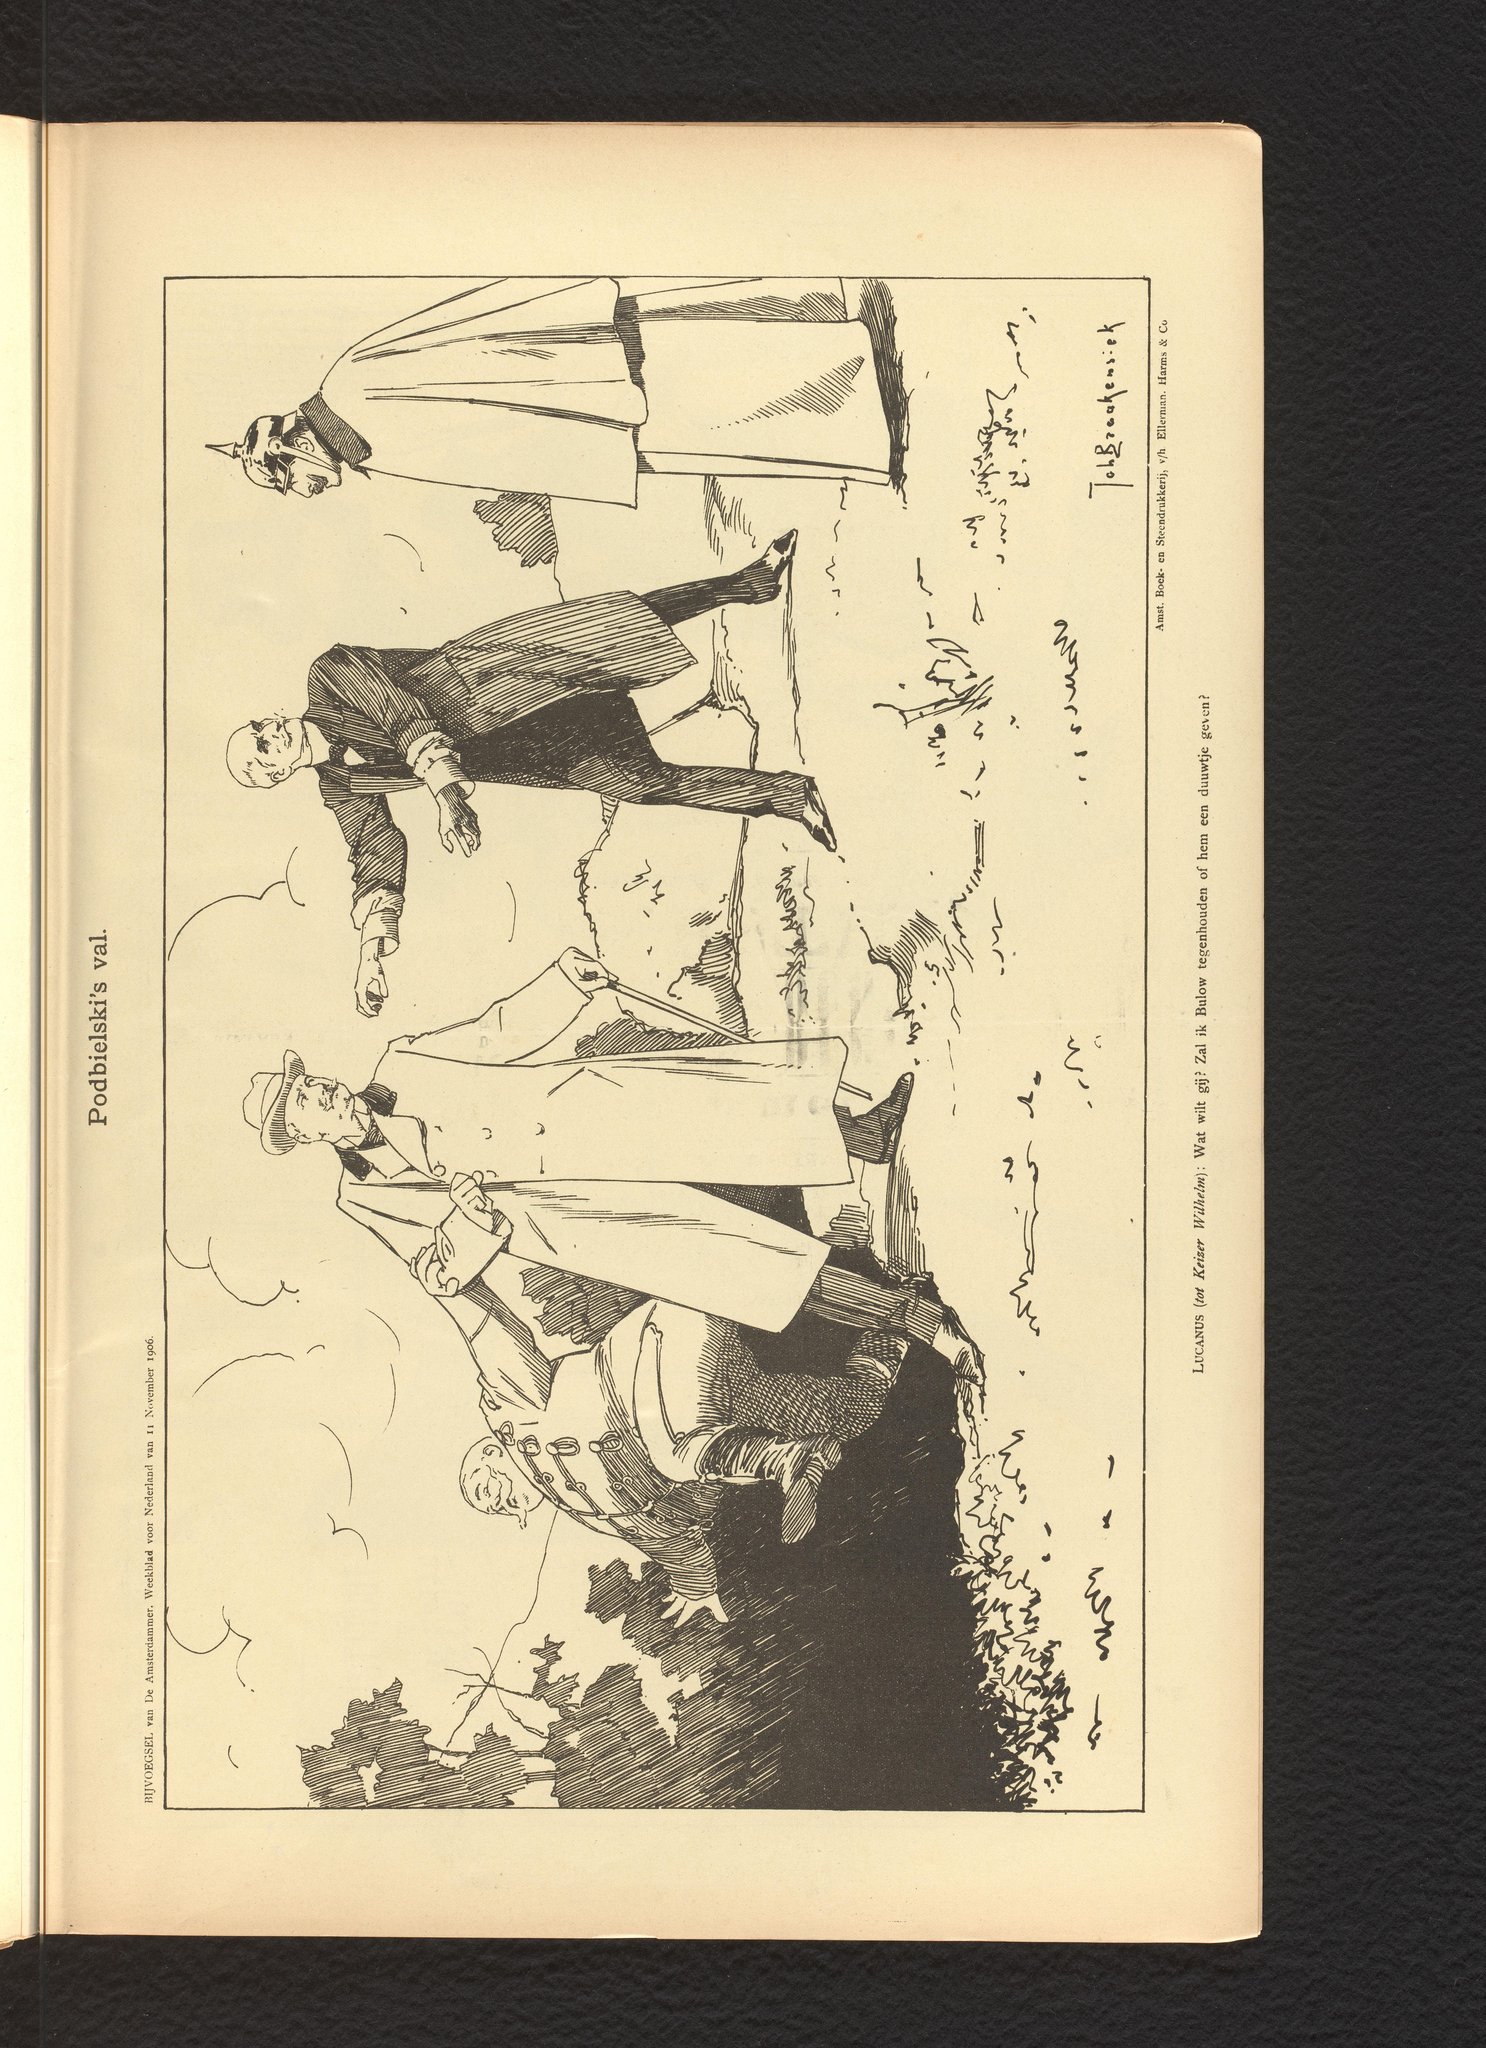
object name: cartoon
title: Podbielski's val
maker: johan braakensiek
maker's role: draughtsman, print maker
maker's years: 1858-1940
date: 1906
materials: paper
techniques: lithograph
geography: netherlands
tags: wilhelm ii (keizer van duitsland), falling, political caricatures and satires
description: Victor von Podbielski ( preußischen Landwirtschaftsminister) op de rand van de afgrond houdt zich nog vast aan de arm van kanselier Von Bülow. Hermann von Lucanus vraagt aan de Duitse keizer Wilhelm II of hij Bülow ook een zet moet geven.